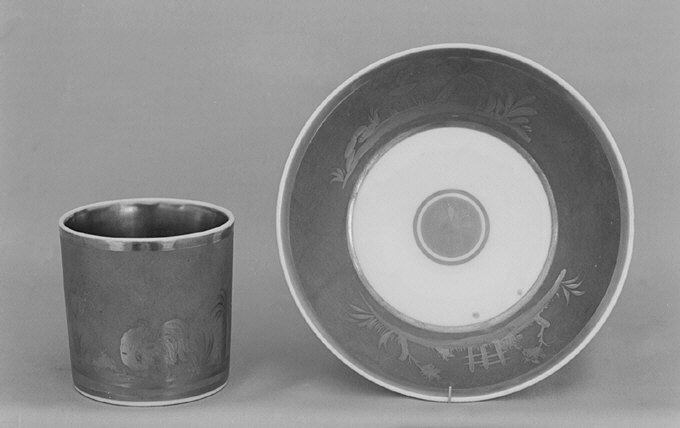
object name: cup and saucer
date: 1801-1833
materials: hard paste porcelain